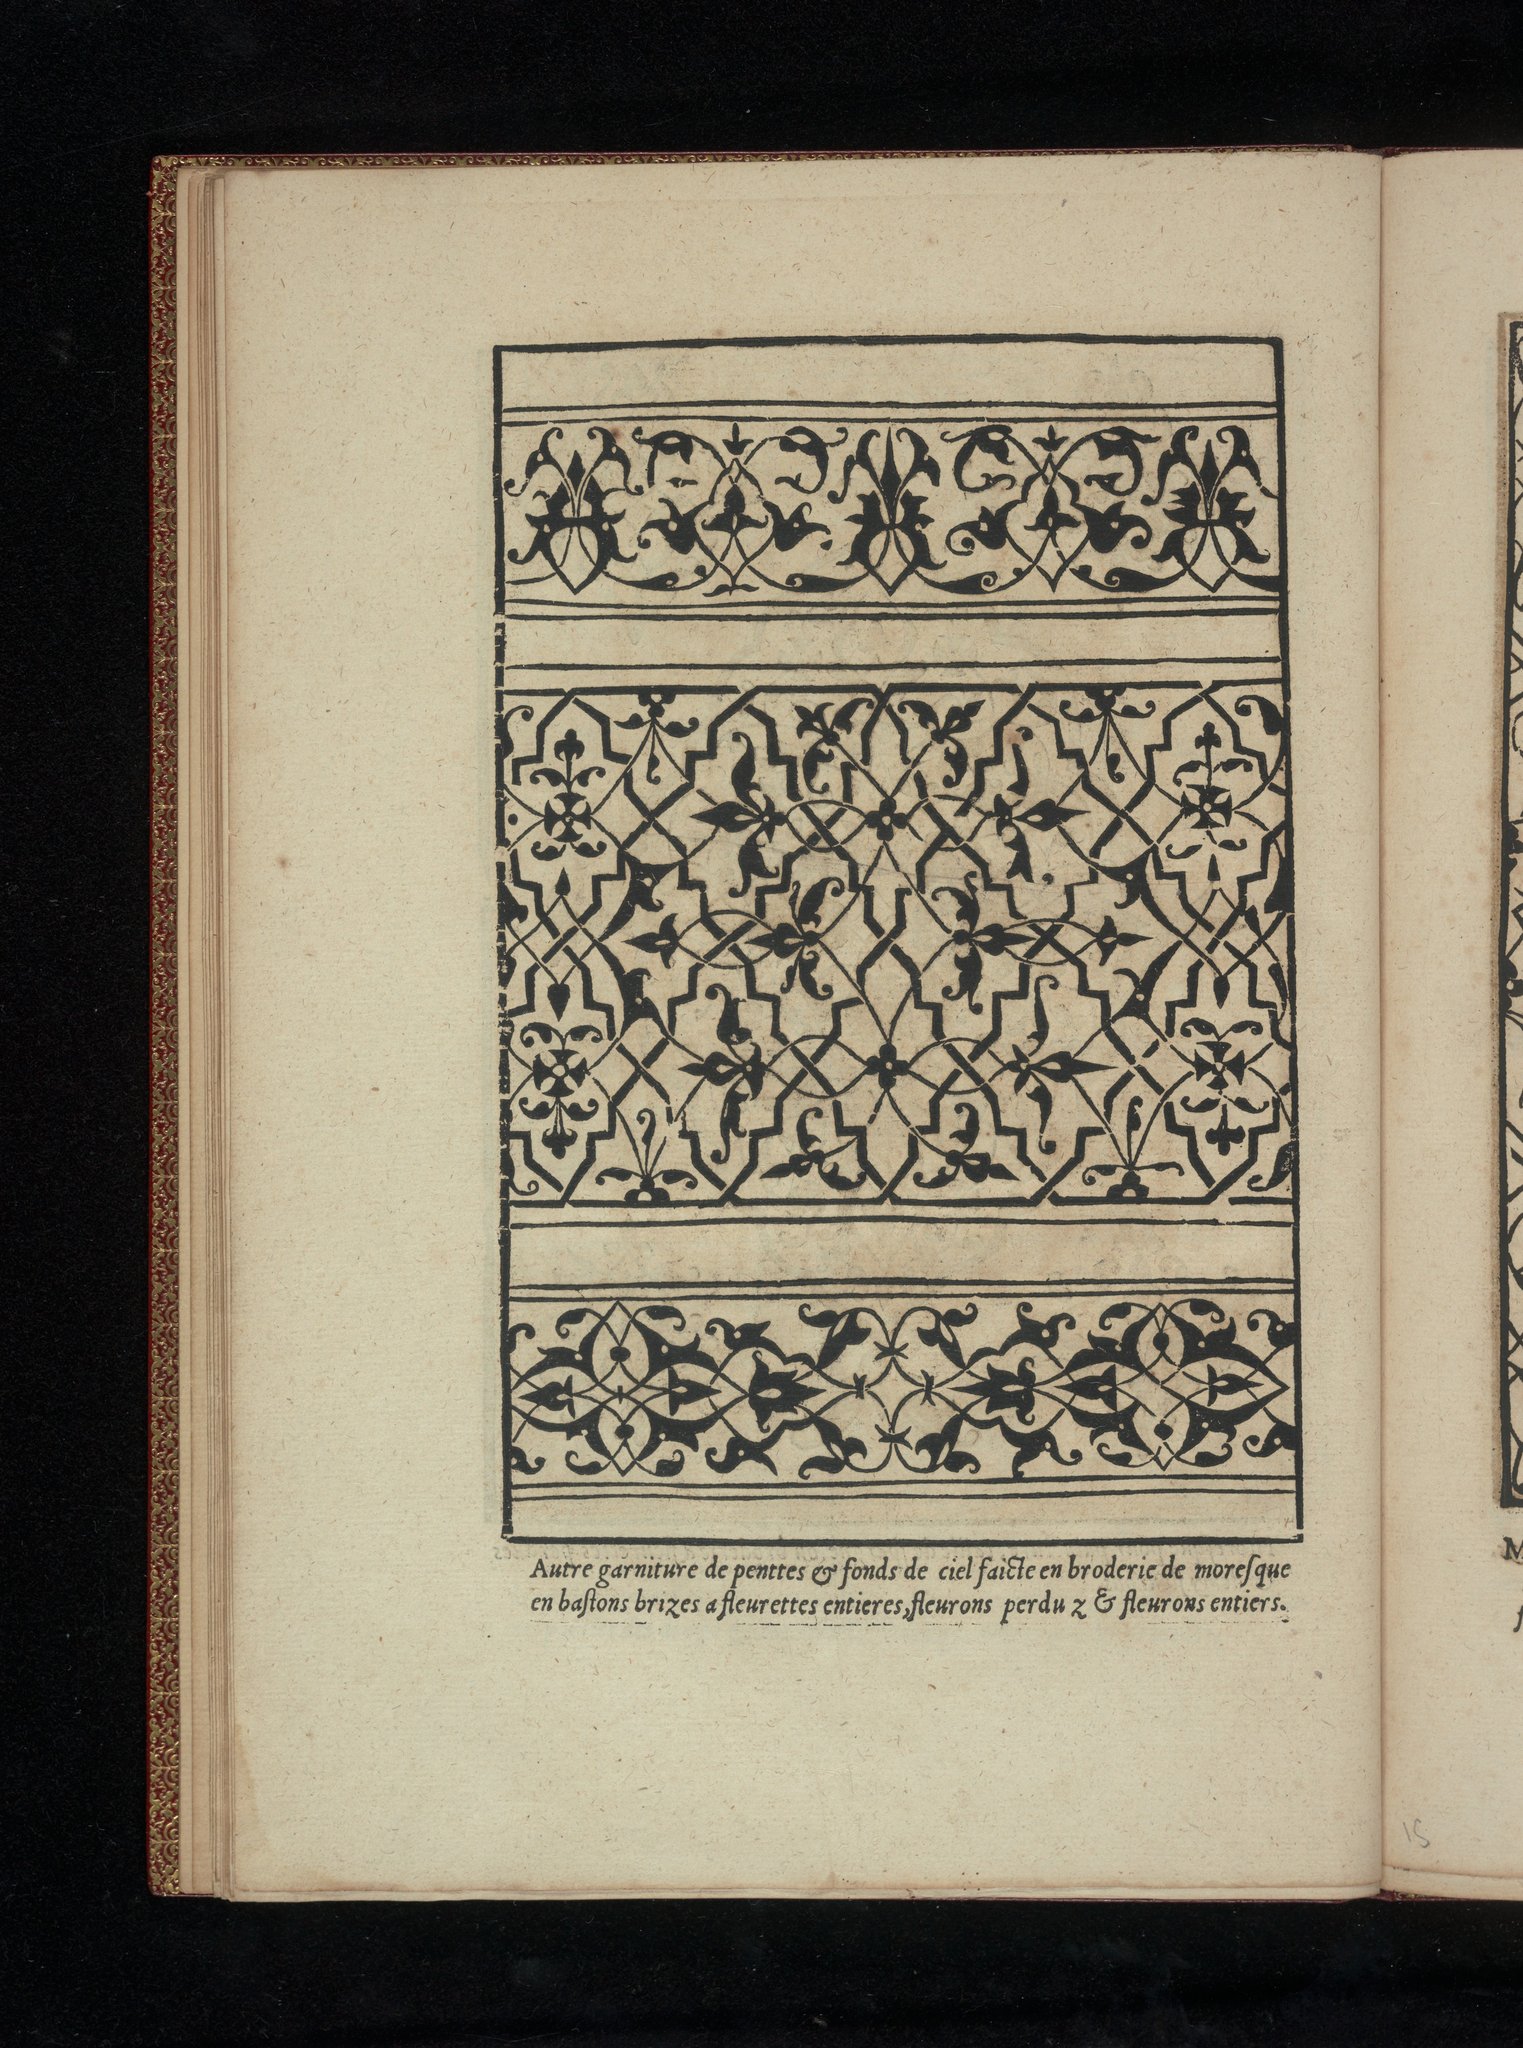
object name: book print ornament architecture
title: Livre de Moresques, page 15 (verso)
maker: francesco di pellegrino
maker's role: artist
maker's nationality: italian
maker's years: 1525-1552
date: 1546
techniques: woodcut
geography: france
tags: ornament